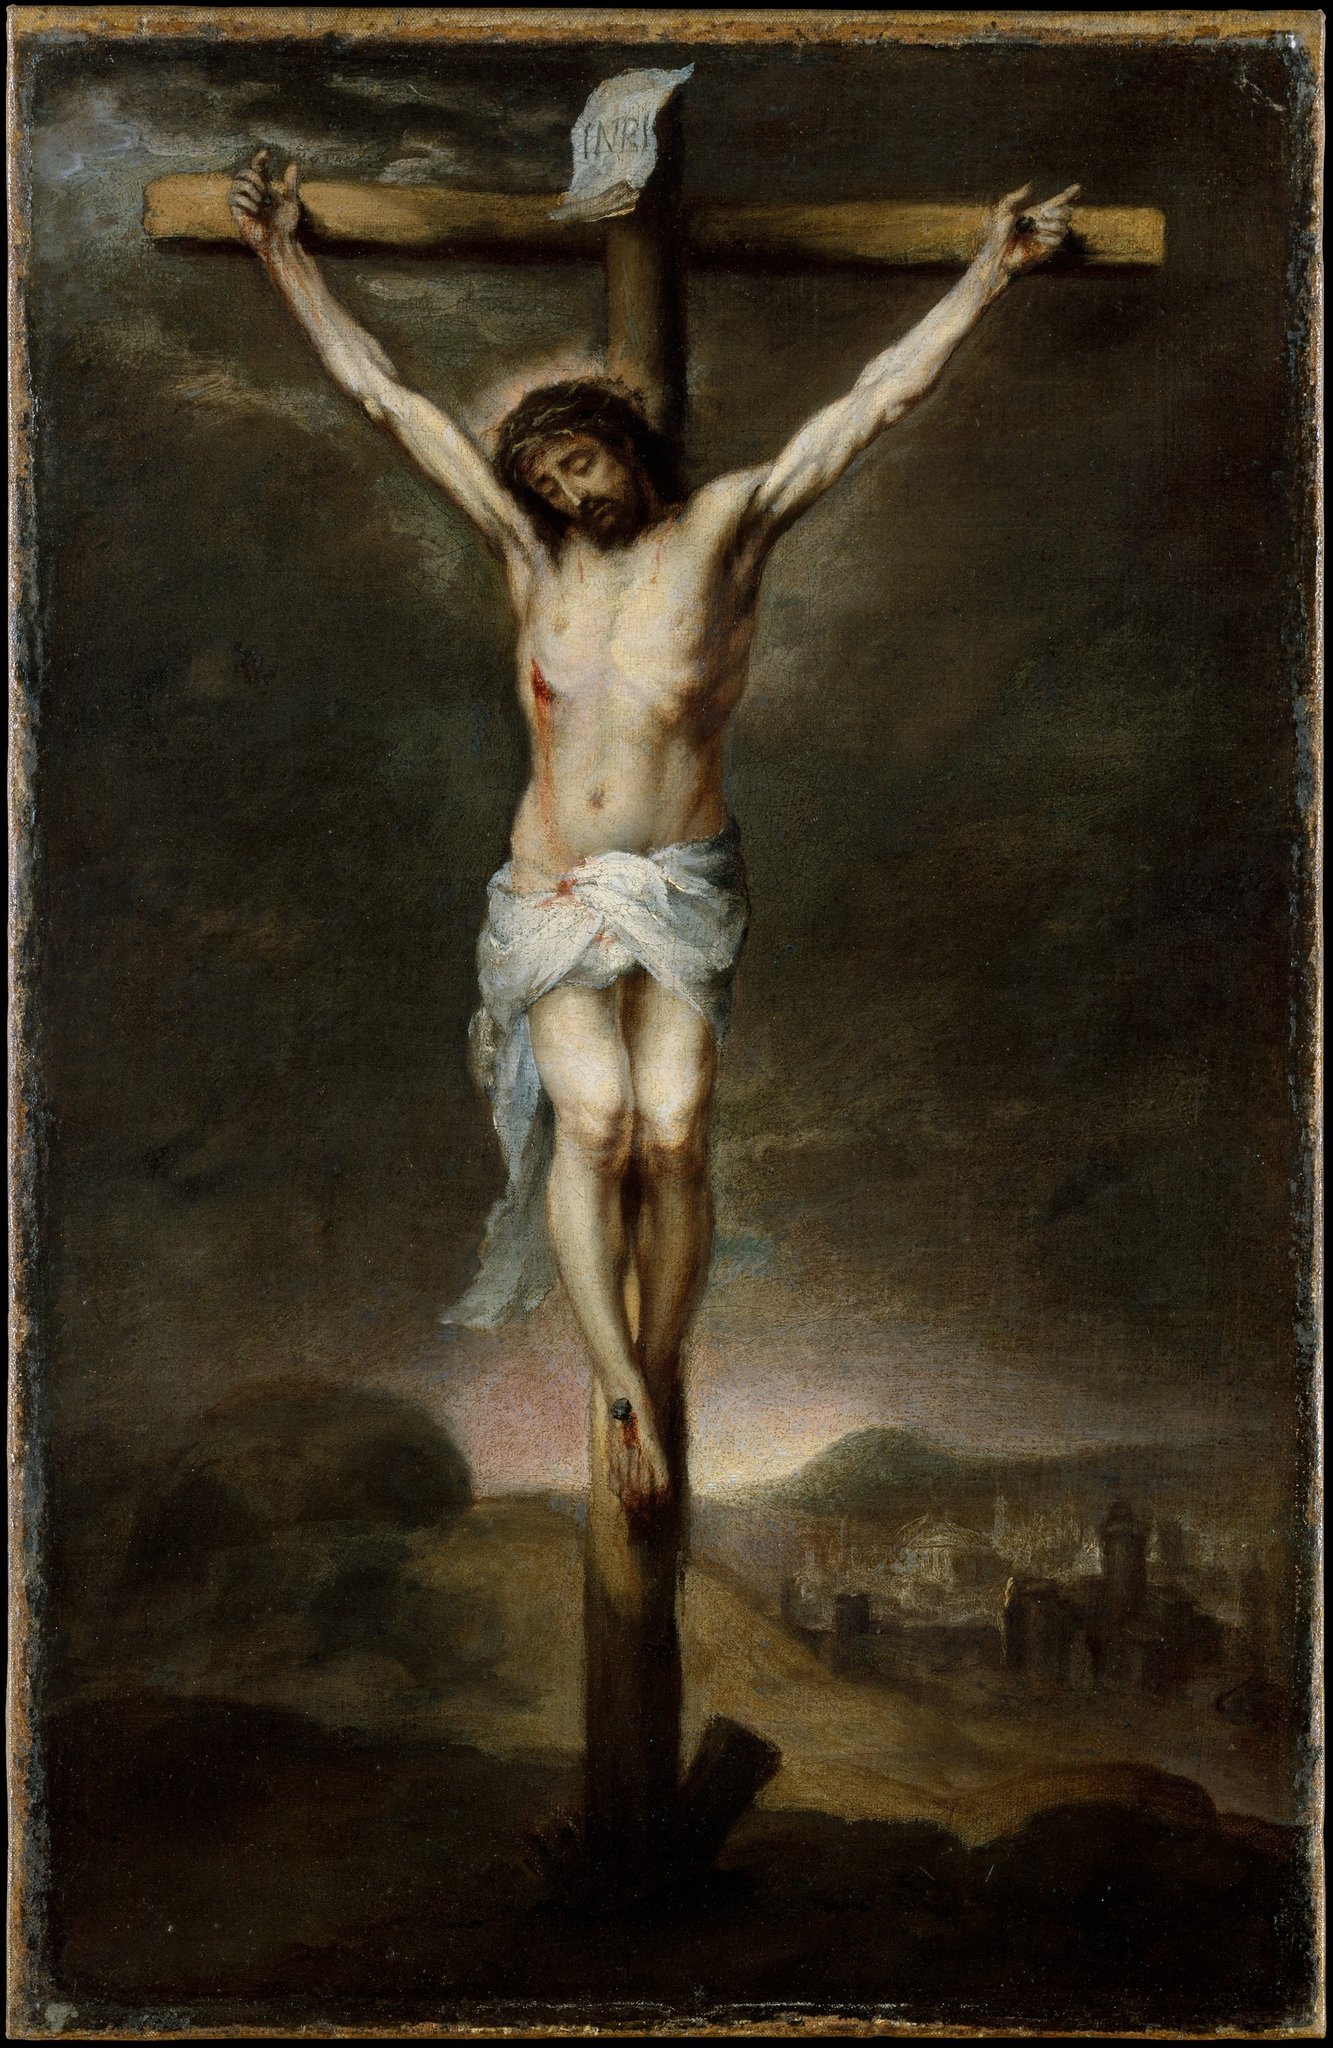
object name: painting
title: The Crucifixion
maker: bartolomé estebán murillo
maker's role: artist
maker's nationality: spanish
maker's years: 1617-1682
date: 1675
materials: canvas, oil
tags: christ,cross,crucifixion